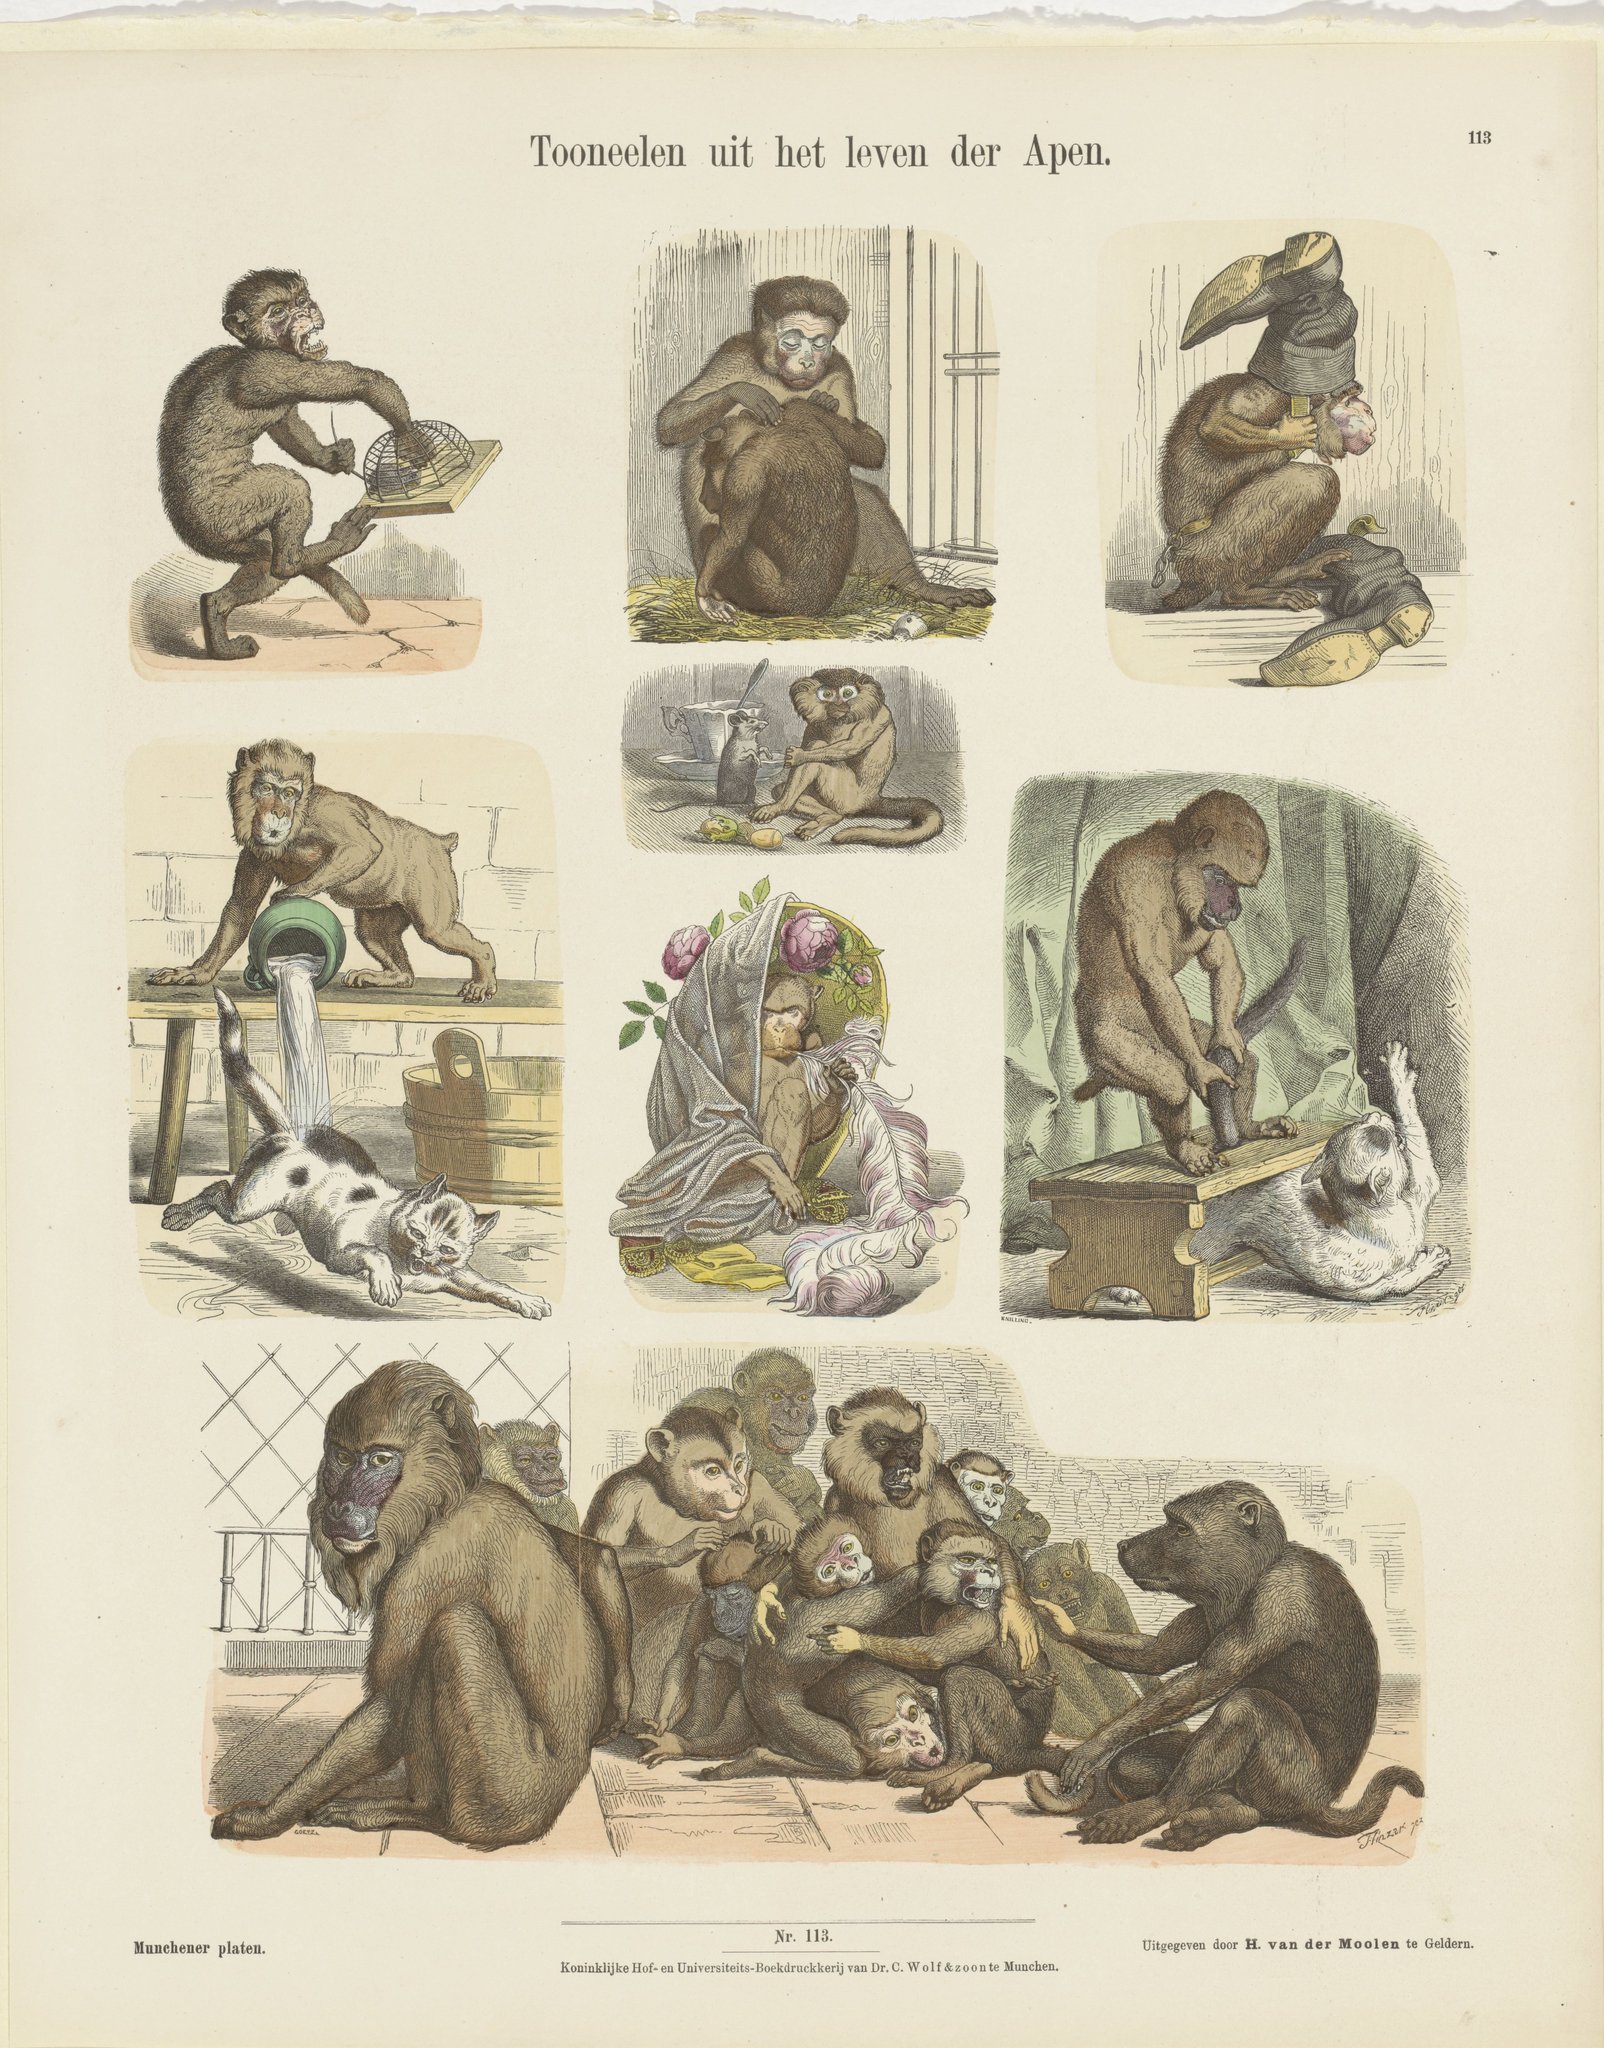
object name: print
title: Tooneelen uit het leven der apen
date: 1843-1920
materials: paper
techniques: colour, letterpress printing, engraving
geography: geldern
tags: monkeys, apes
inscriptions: collector's mark: Lugt 2760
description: Nederlandse editie van een prent uit de reeks "Munchener platen" uitgegeven door K. Braun & Fr. Schneider te München met het adres van wederverkoper Hermann van der Moolen.